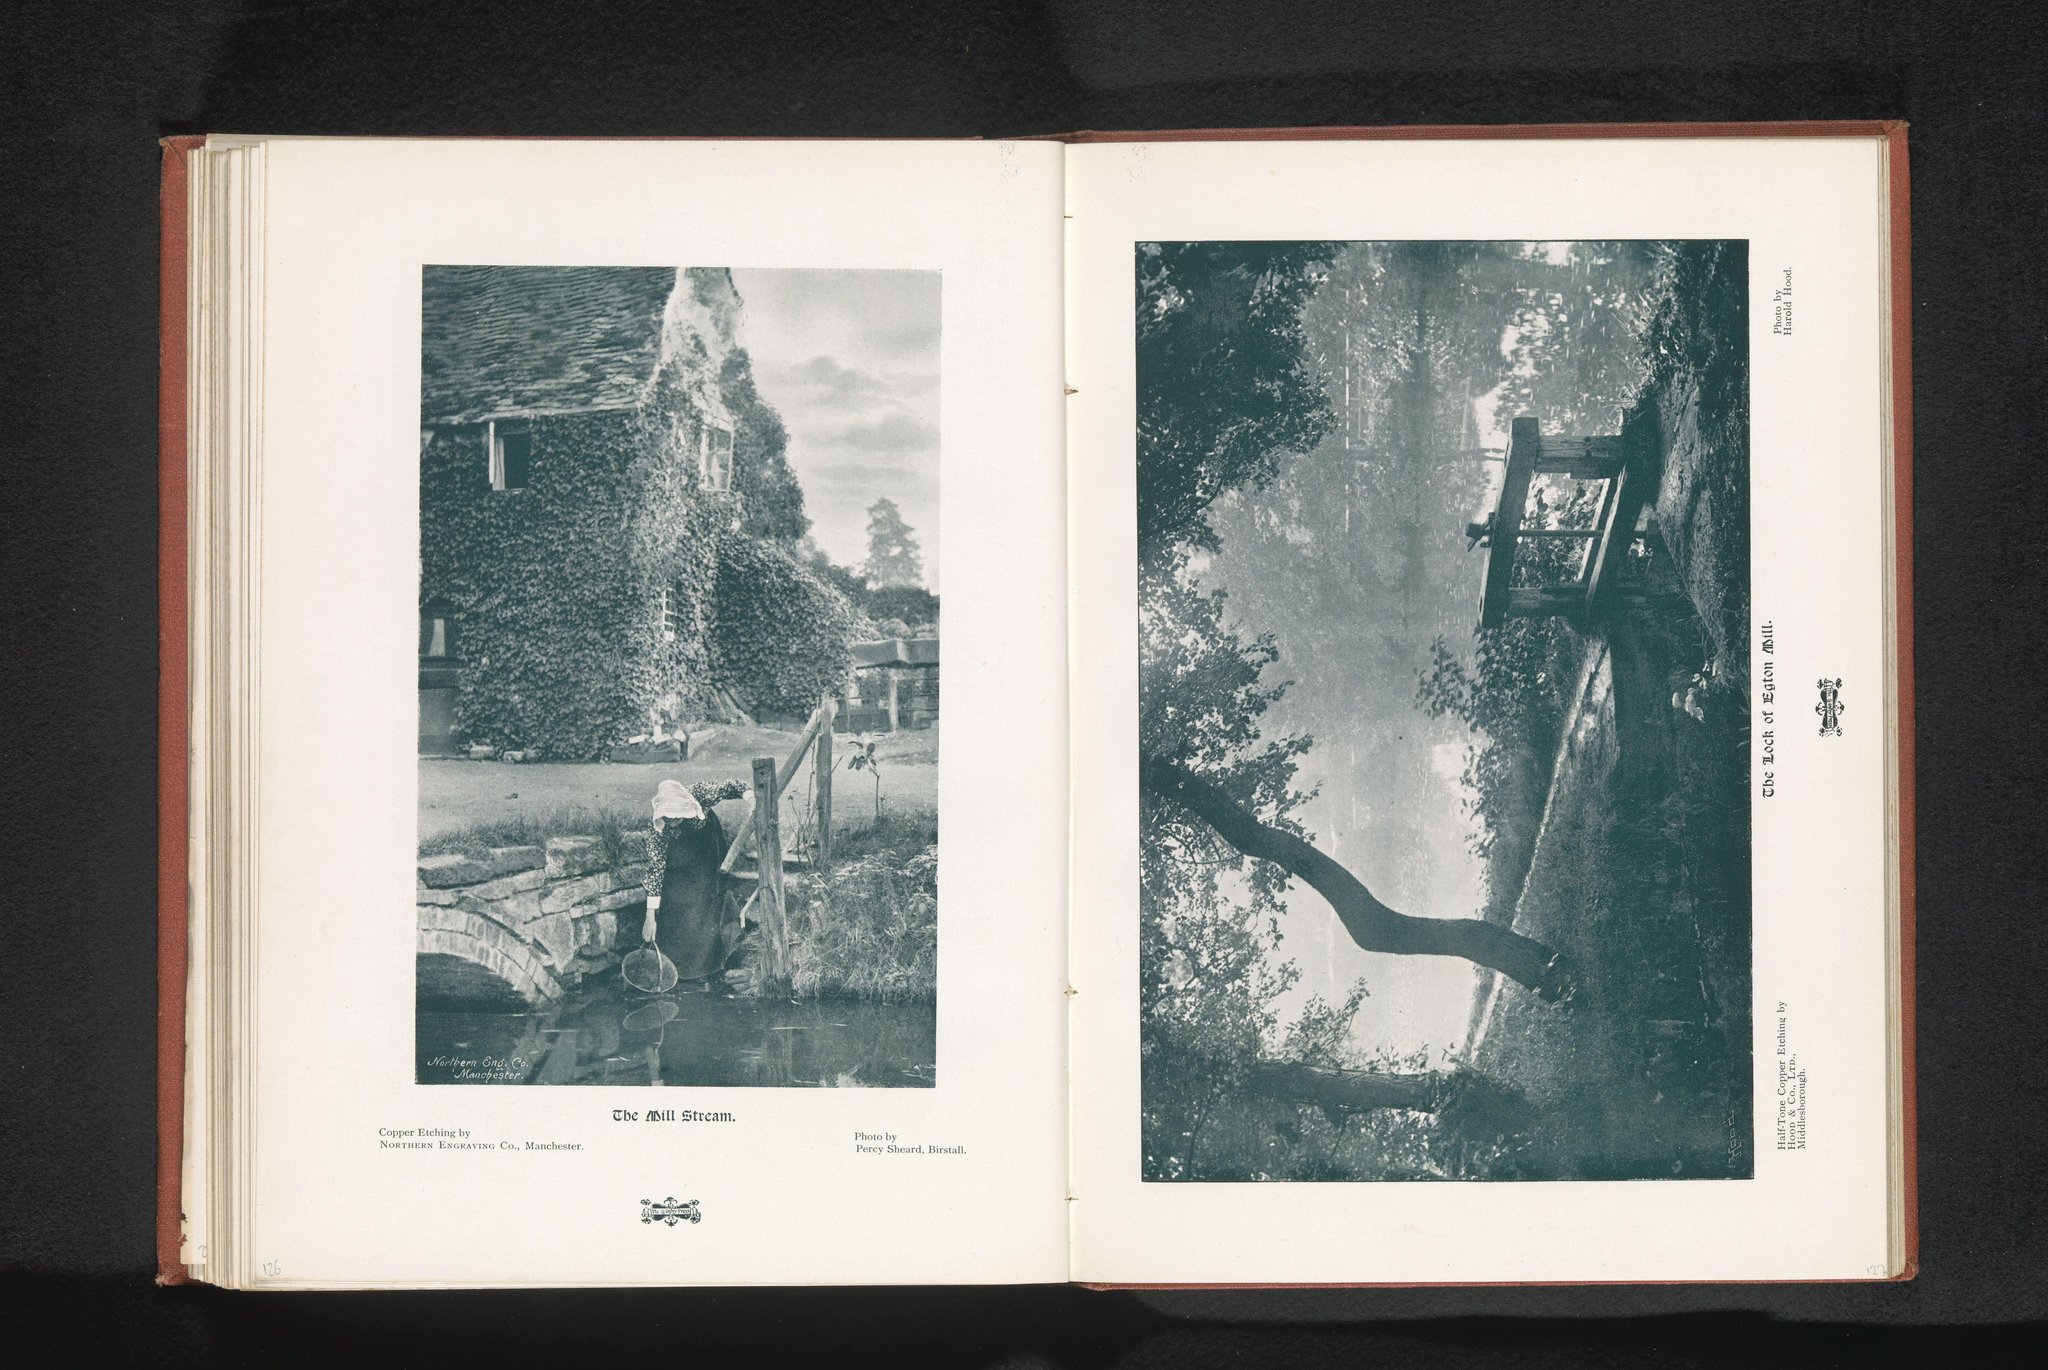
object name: photomechanical print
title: The mill stream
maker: percy sheard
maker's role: fotograaf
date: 1895-1900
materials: paper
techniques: autotype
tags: farmers - aa - female farmer, farmer's wife, village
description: Prent op tweede ongenummerde pagina na pagina 104.